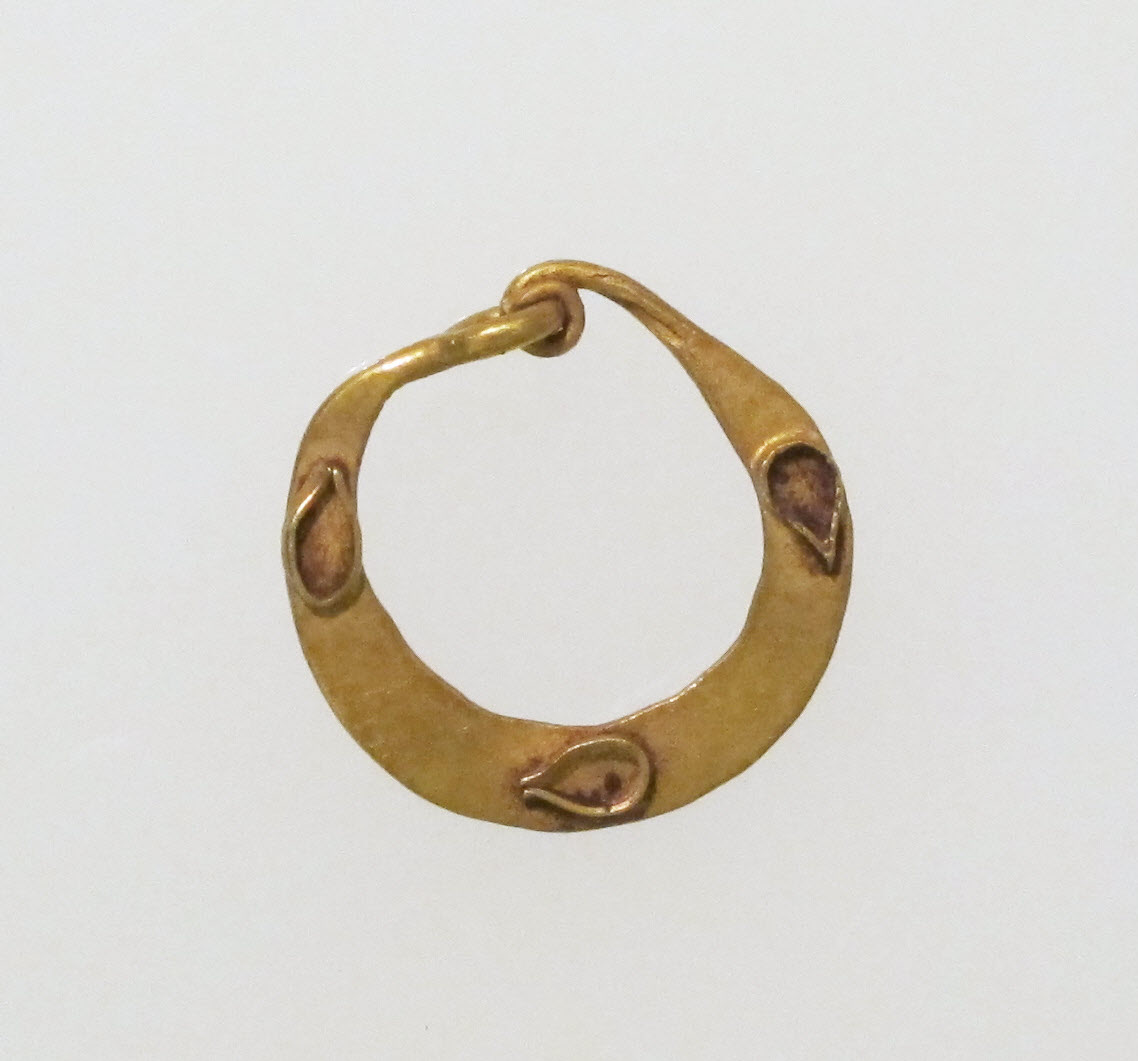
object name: earring, crescent shaped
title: Earring, crescent-shaped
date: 7000 BCE-330 CE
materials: gold